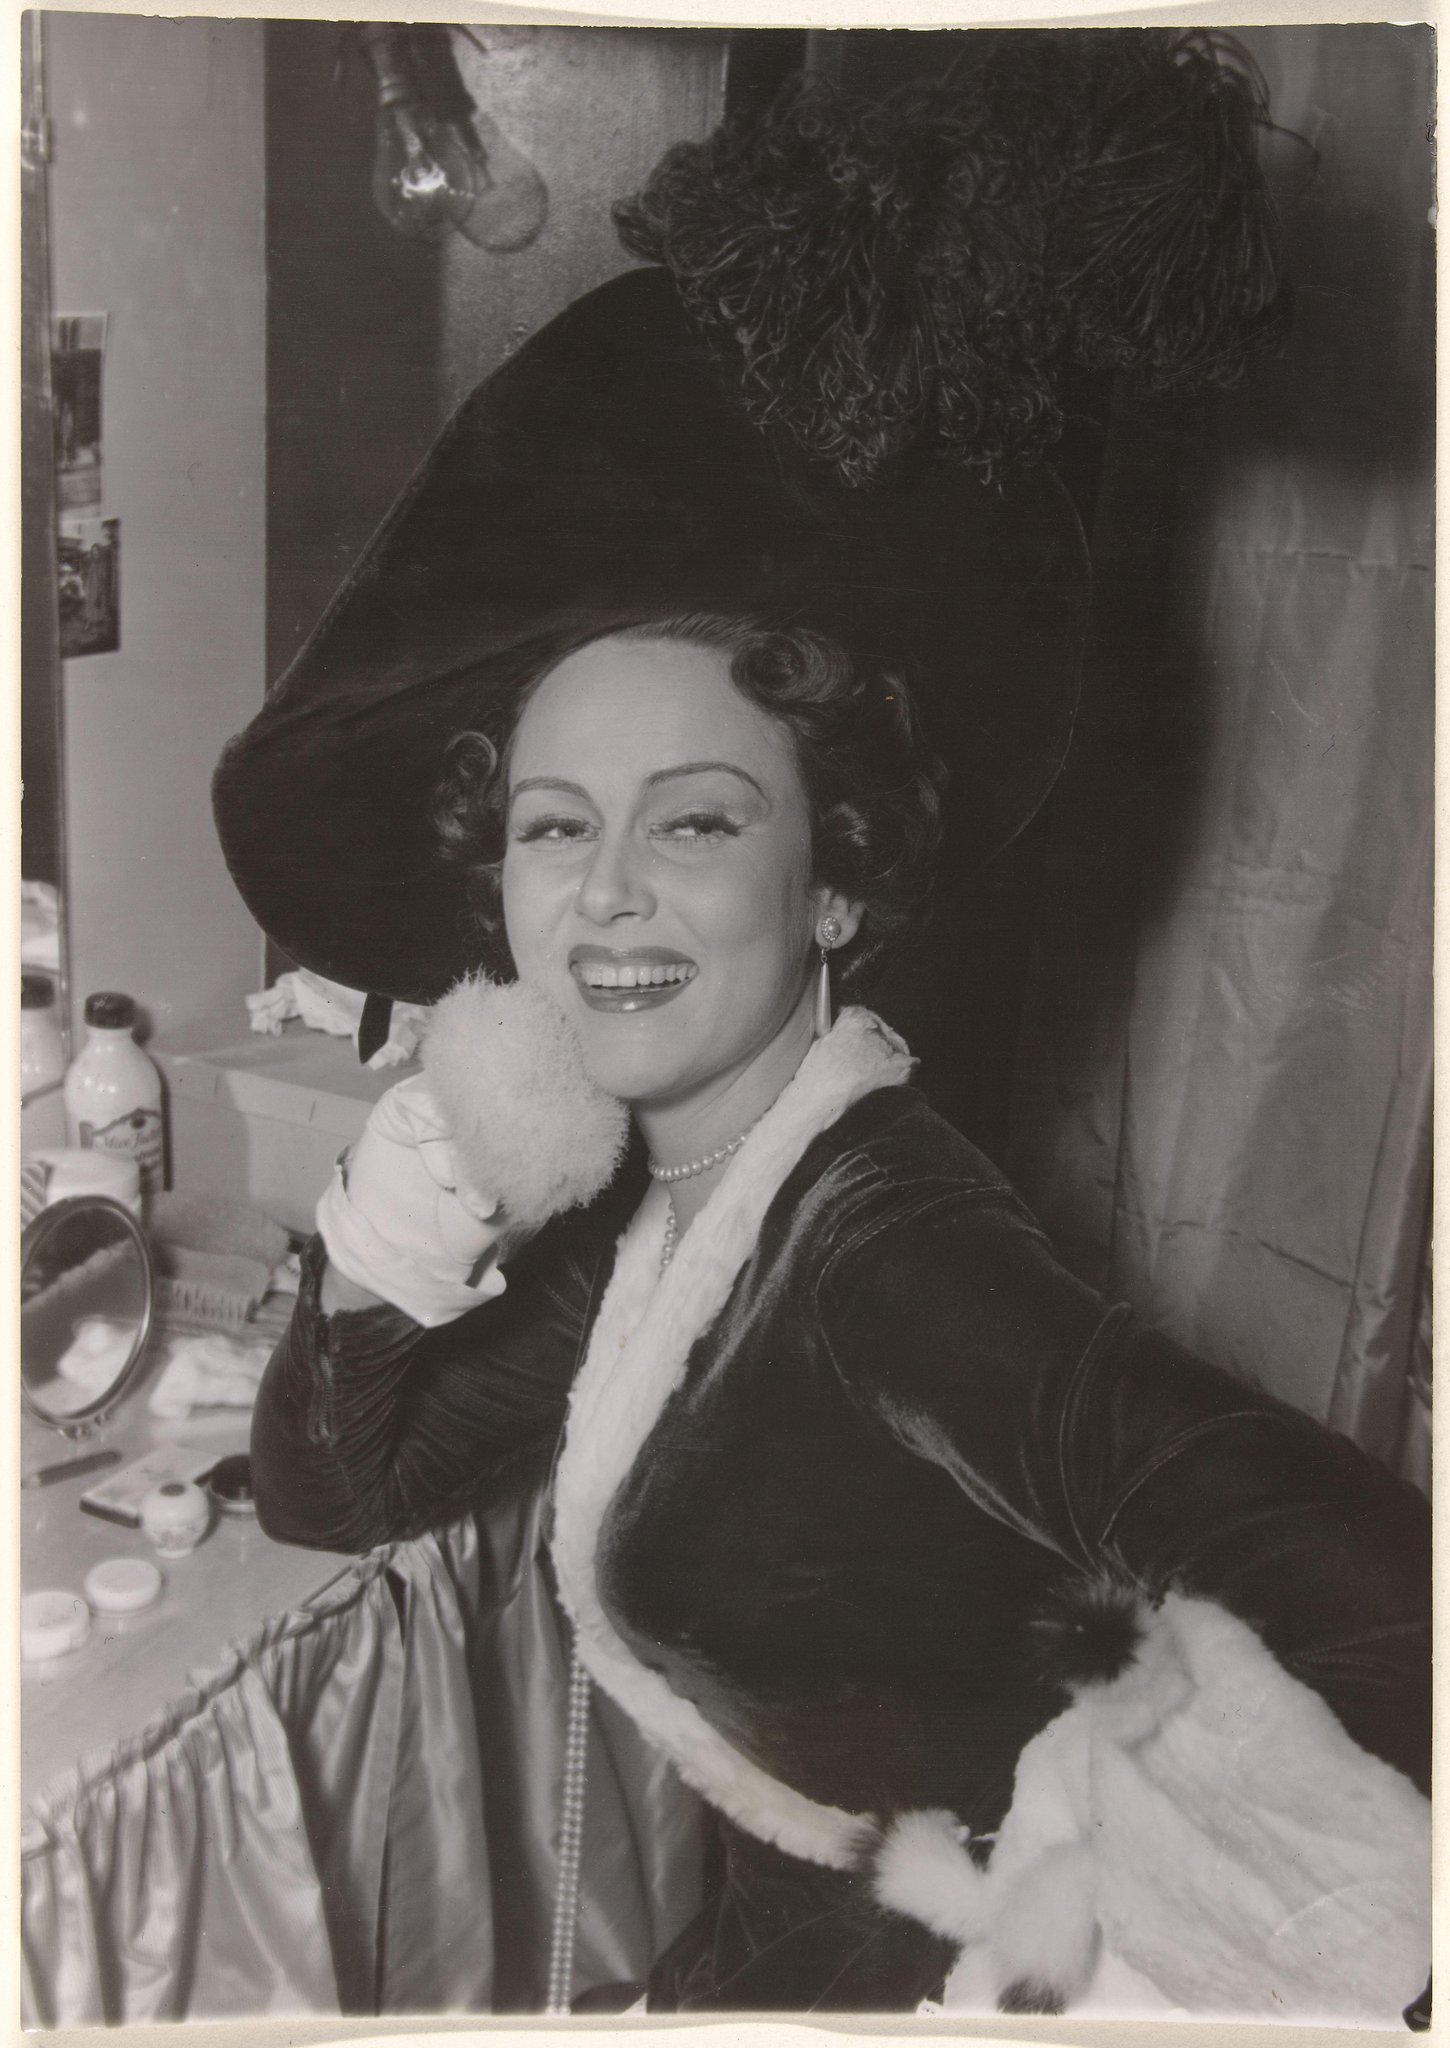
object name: photograph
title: Nadia Gray in 'Le Petit Cafe' van Tristan Bernard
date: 1949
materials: photographic support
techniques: gelatin silver print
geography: paris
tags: new york (city), paris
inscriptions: inscription: ‘Le petit cafe ouvre ses portes’